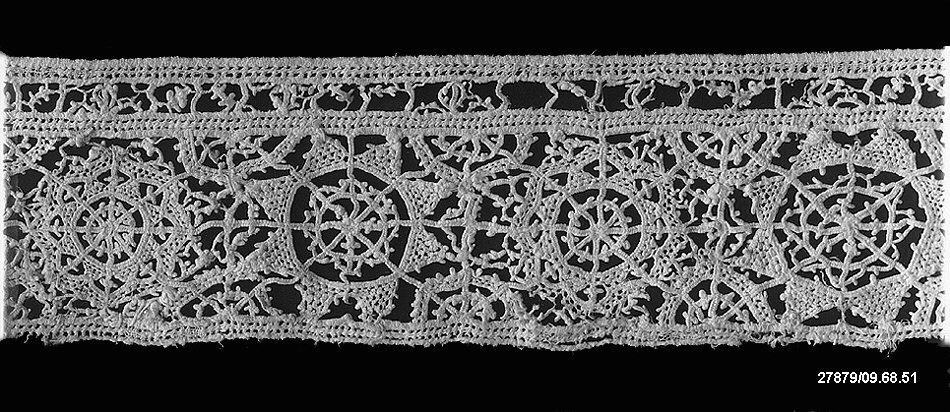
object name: strip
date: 1501-1700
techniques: lace